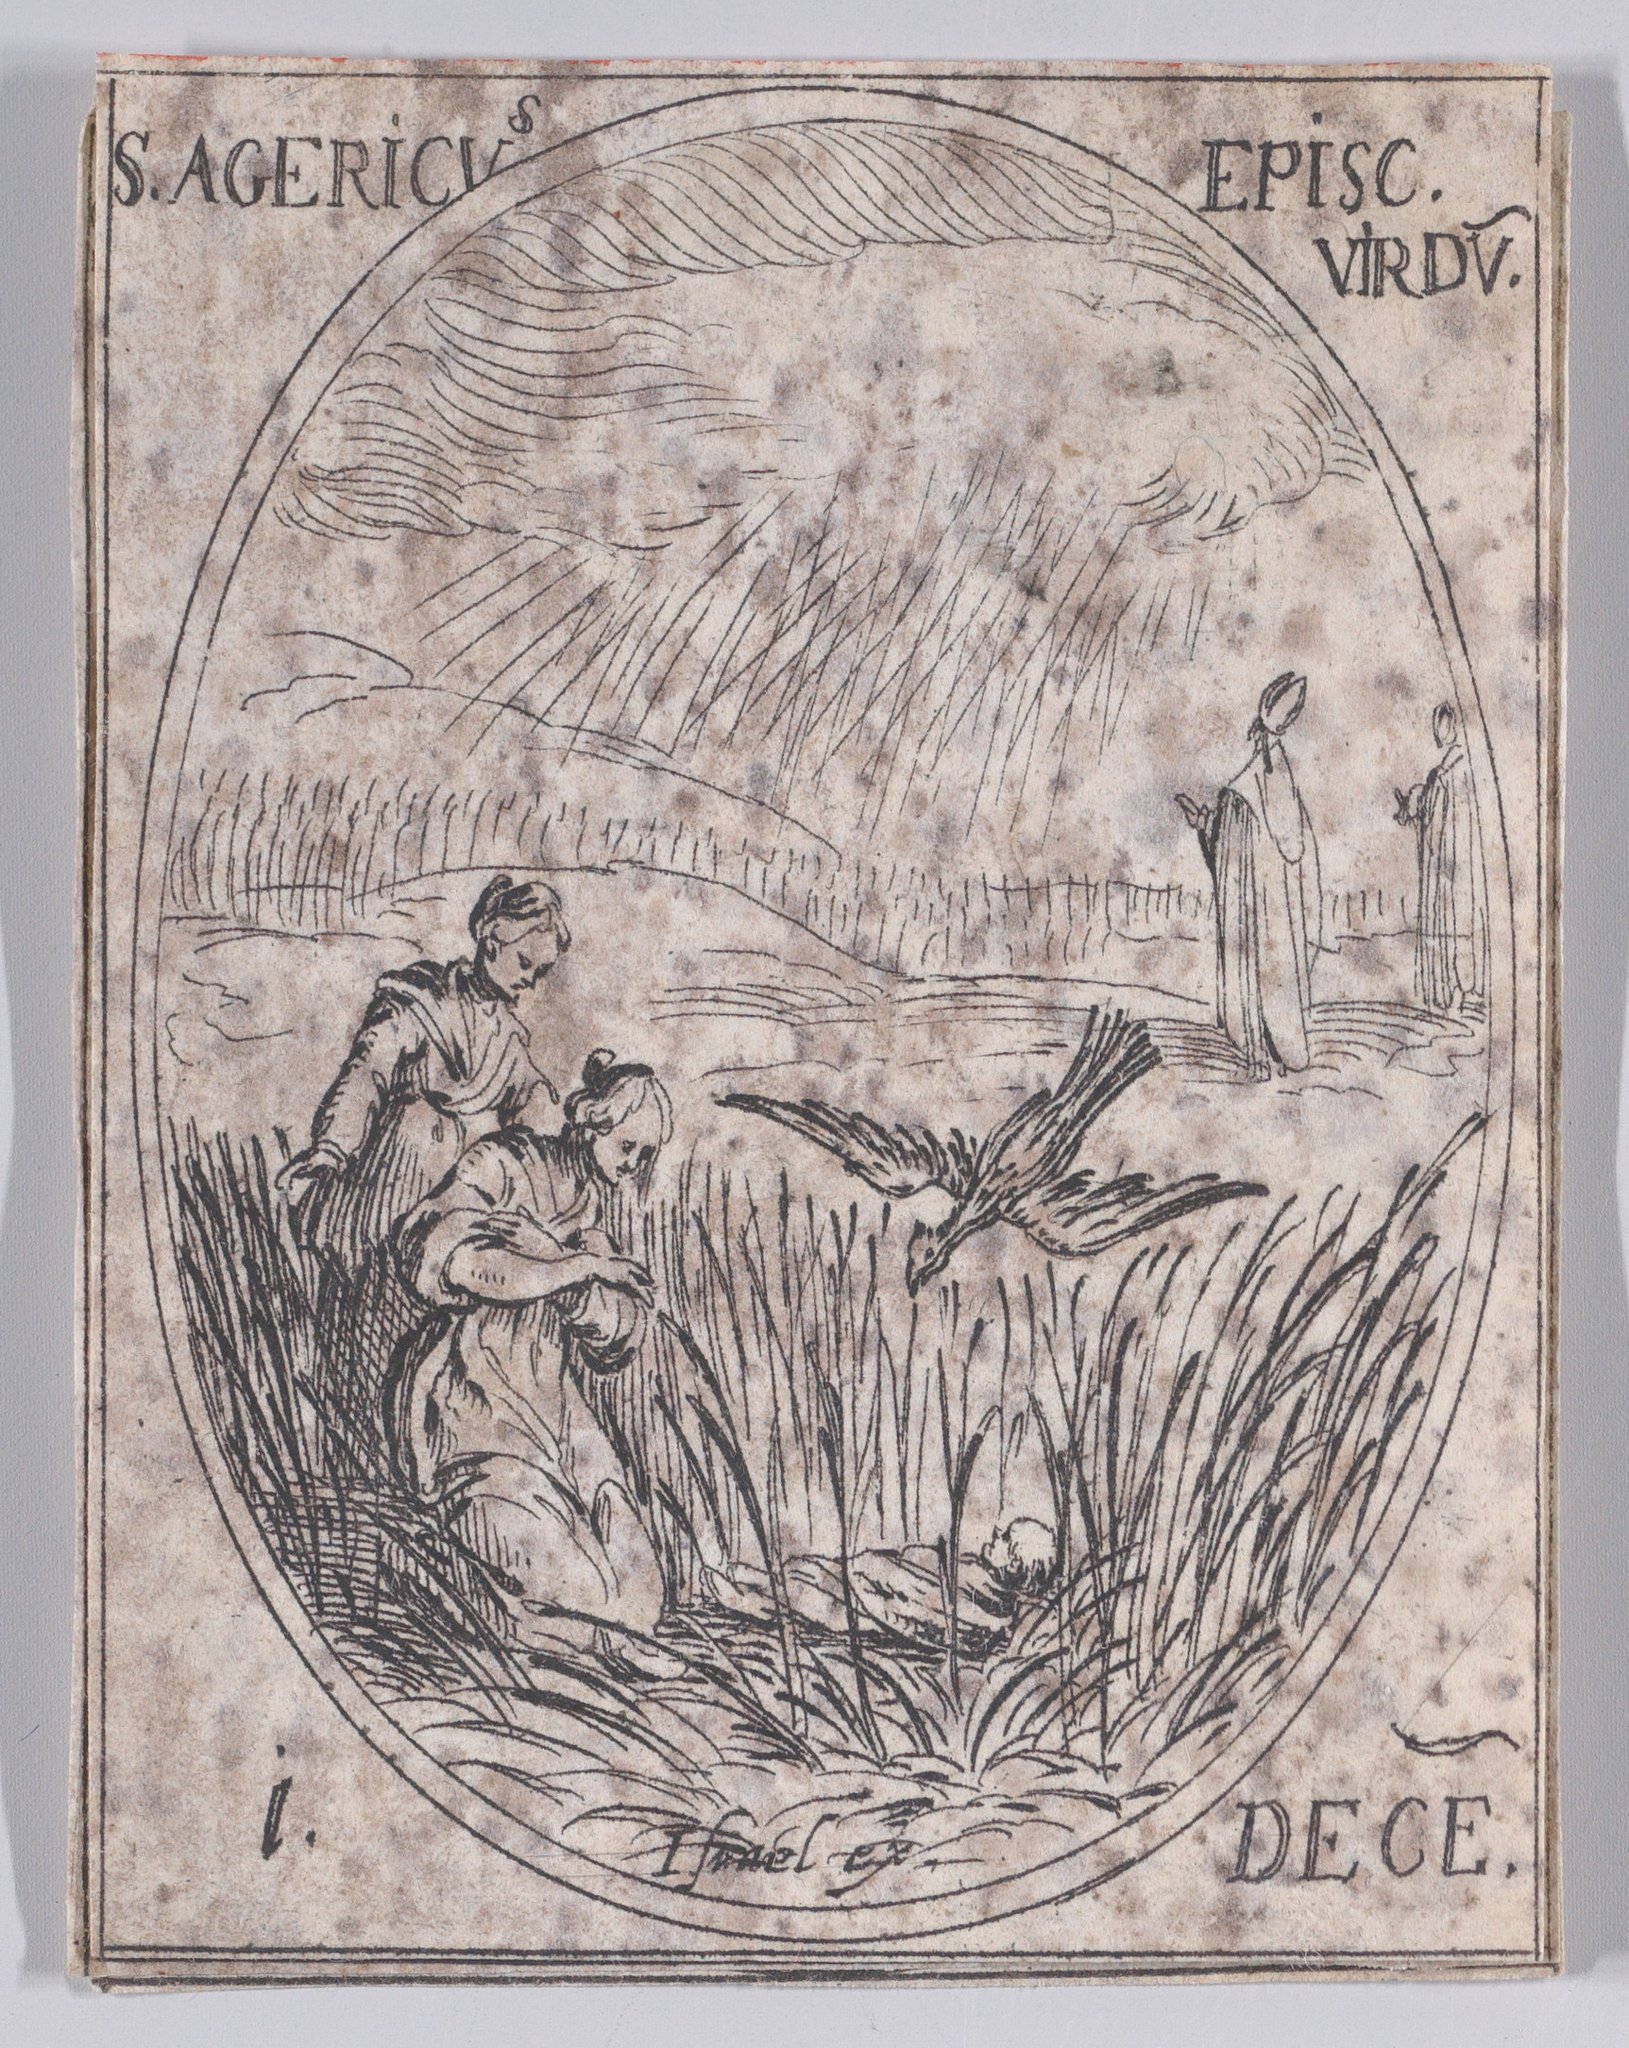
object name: print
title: S. Aigri, évêque de Verdun (St. Agericus, Bishop of Verdun), December 1st, from "Les Images De Tous Les Saincts et Saintes de L'Année" (Images of All of the Saints and Religious Events of the Year)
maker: jacques callot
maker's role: artist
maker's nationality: french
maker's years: 1592-1635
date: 1636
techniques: etching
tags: birds,men,women,saints